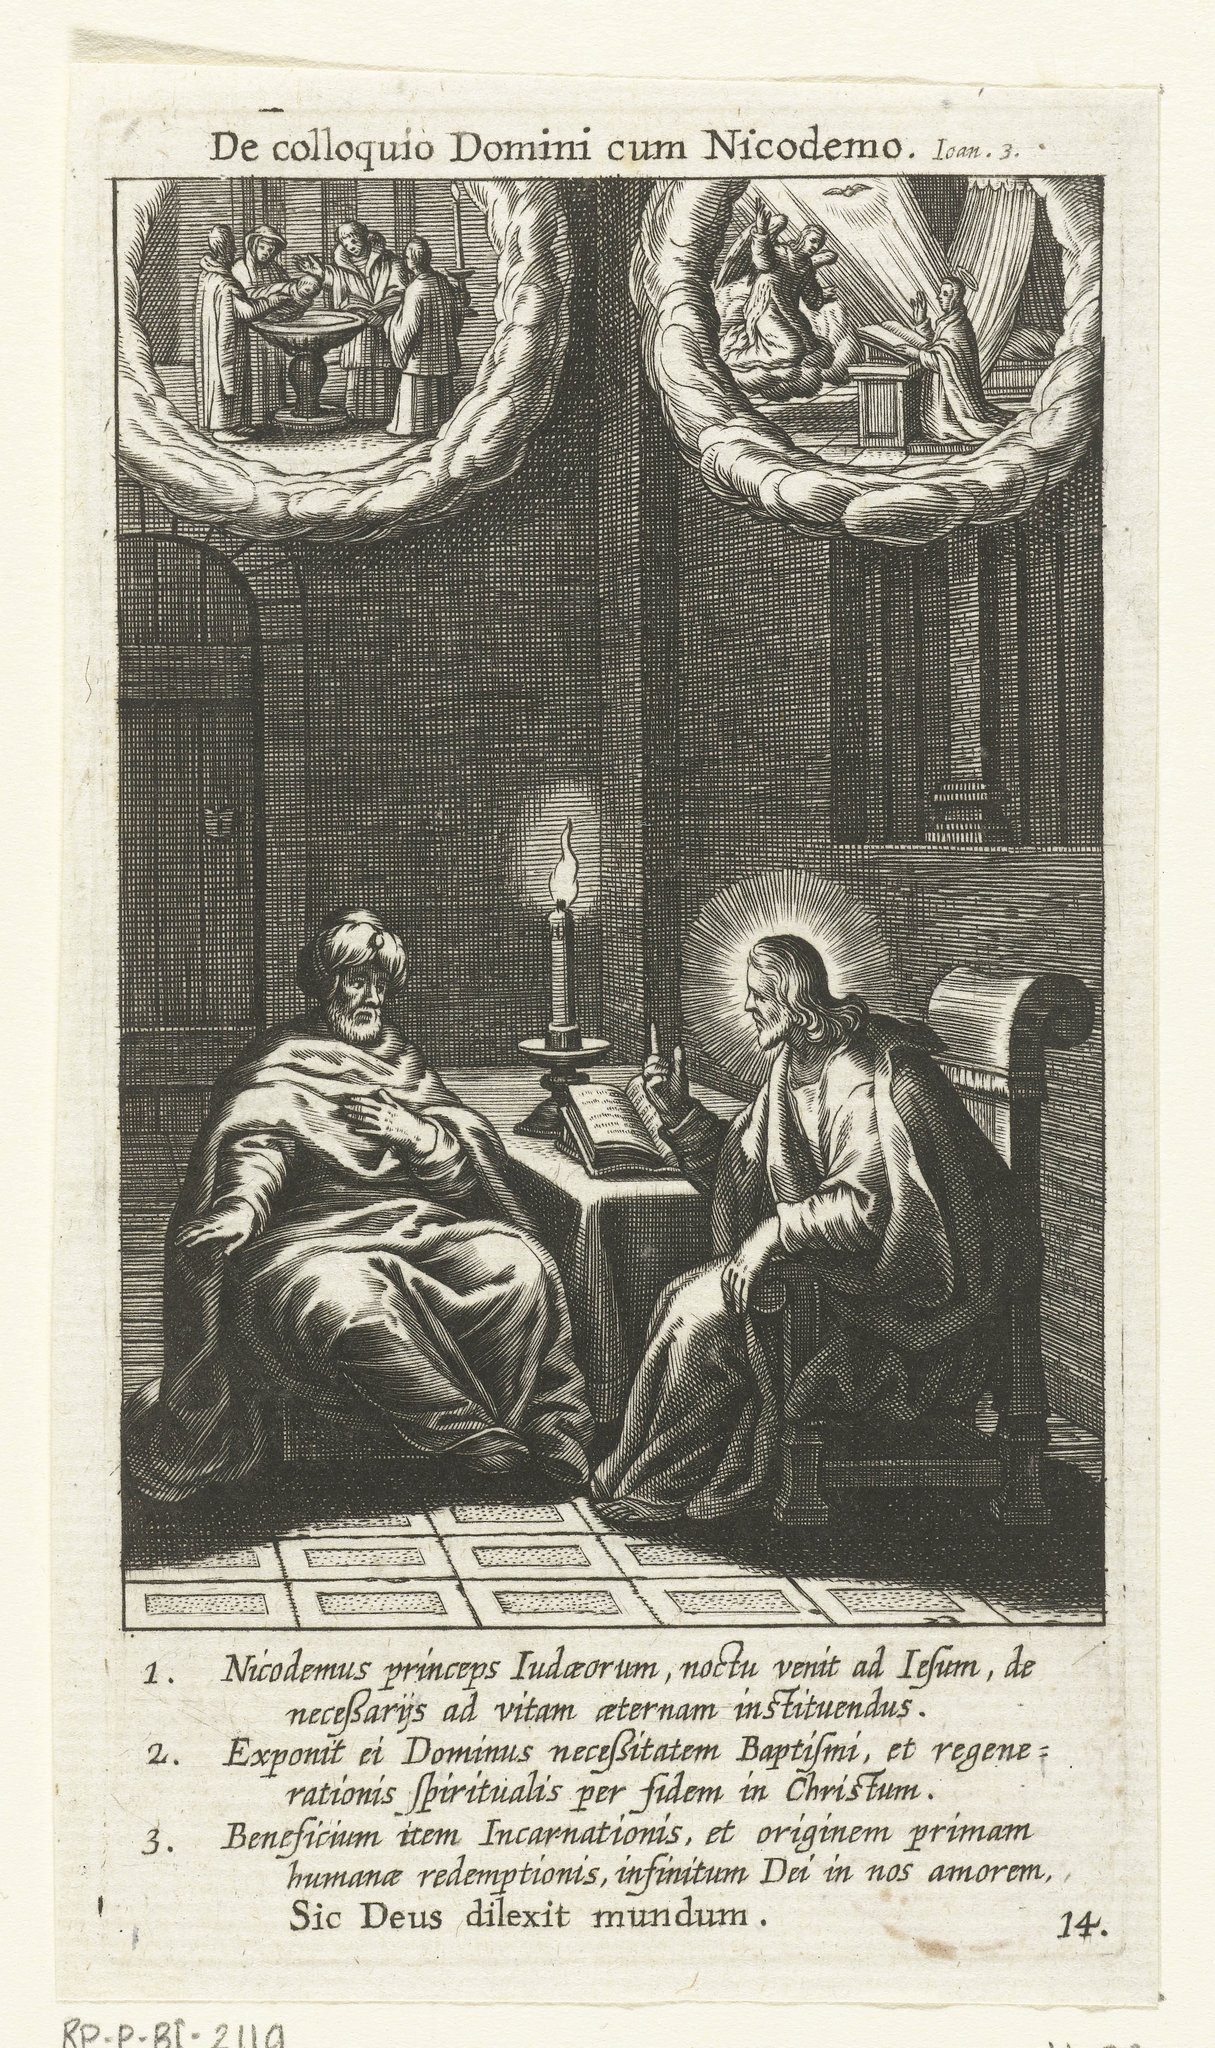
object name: print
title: Christus spreekt met Nicodemus bij nacht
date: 1590-1622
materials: paper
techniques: engraving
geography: antwerp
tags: christ talking with nicodemus at night (john 3:1-21)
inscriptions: collector's mark: Lugt 240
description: Prent uit: Joannes Bourgois, Vitae passionis et mortis Jesu Christi Somini nostri mysteria, Antwerpen Hendrick Aertssens, 1622, afb. 14